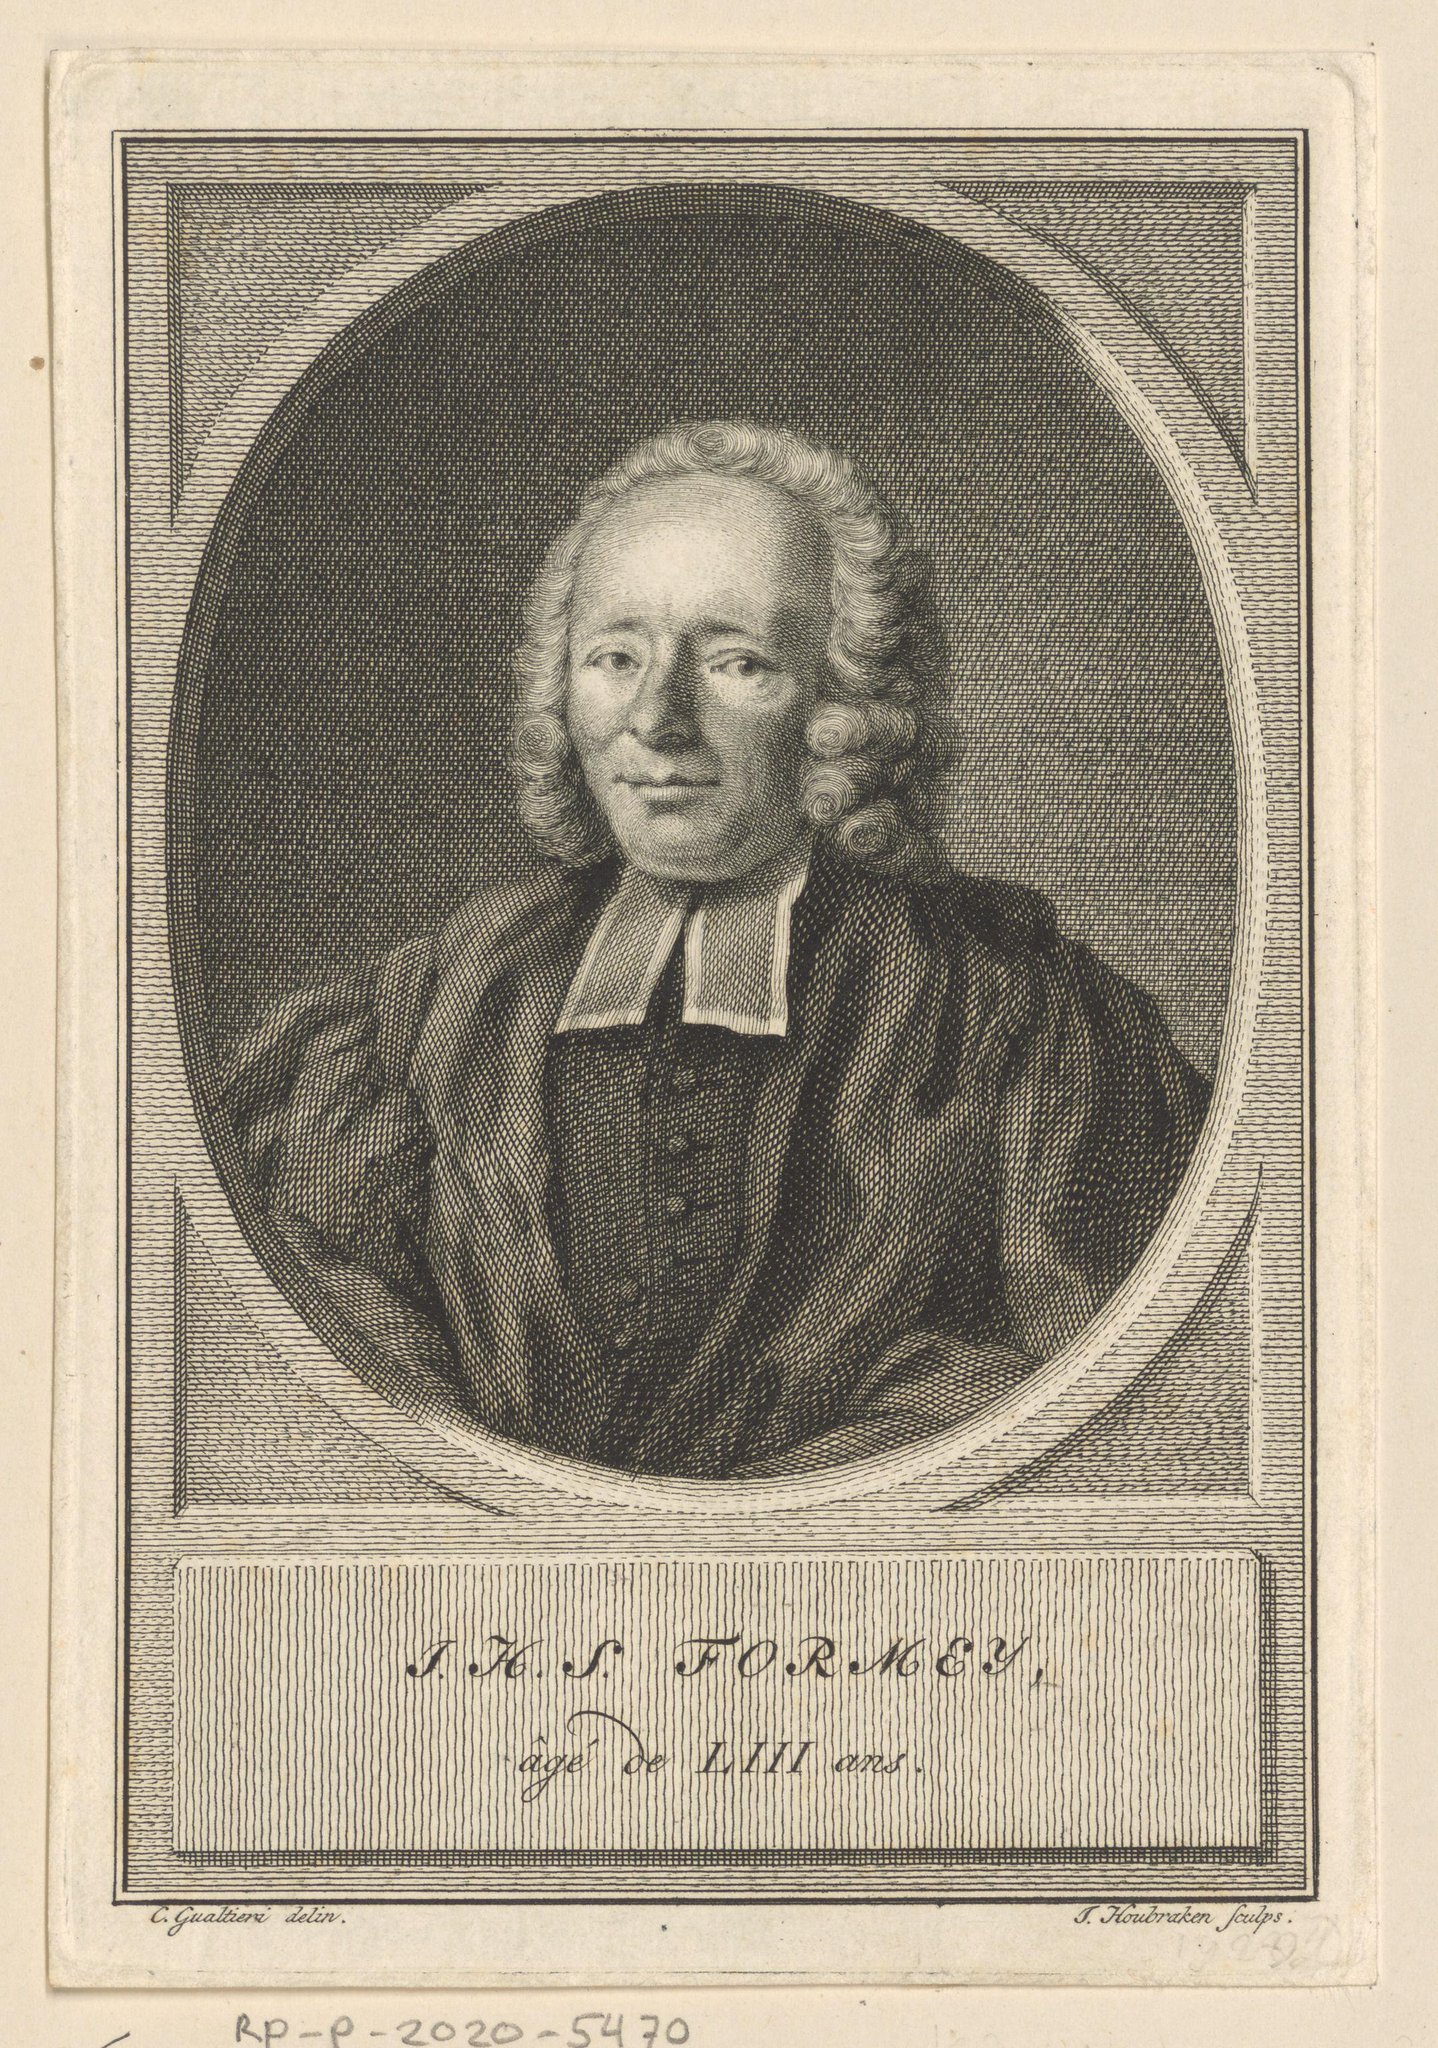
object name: print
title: Portret van Johann Heinrich Samuel Formey op 53-jarige leeftijd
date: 1764-1780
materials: paper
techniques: engraving, etching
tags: berlin, historical persons, portrait of a writer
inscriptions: collector's mark: Lugt 240